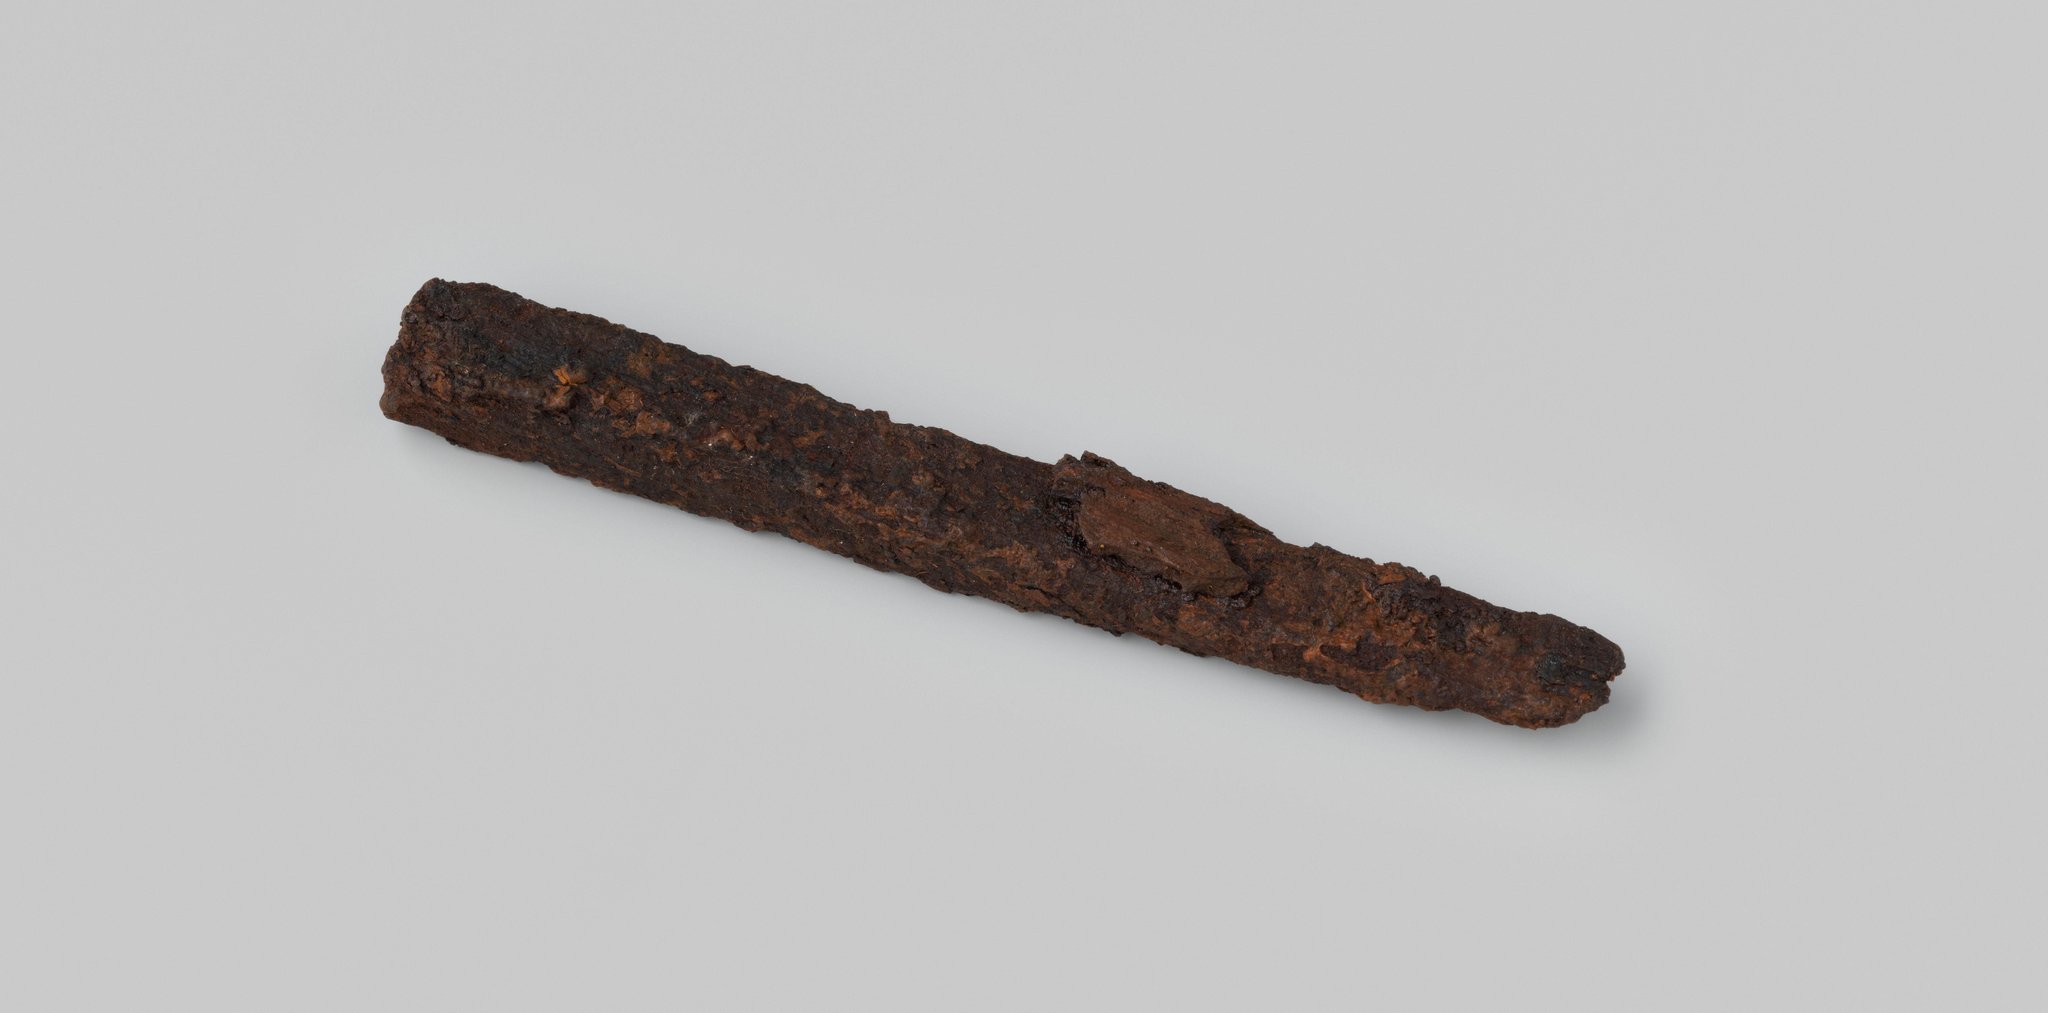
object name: nagel, spijker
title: Spijker afkomstig uit het wrak van de Oost-Indiëvaarder Hollandia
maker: Anonymous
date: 1700-1743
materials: iron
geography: netherlands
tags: verenigde oostindische compagnie, hollandia (schip)